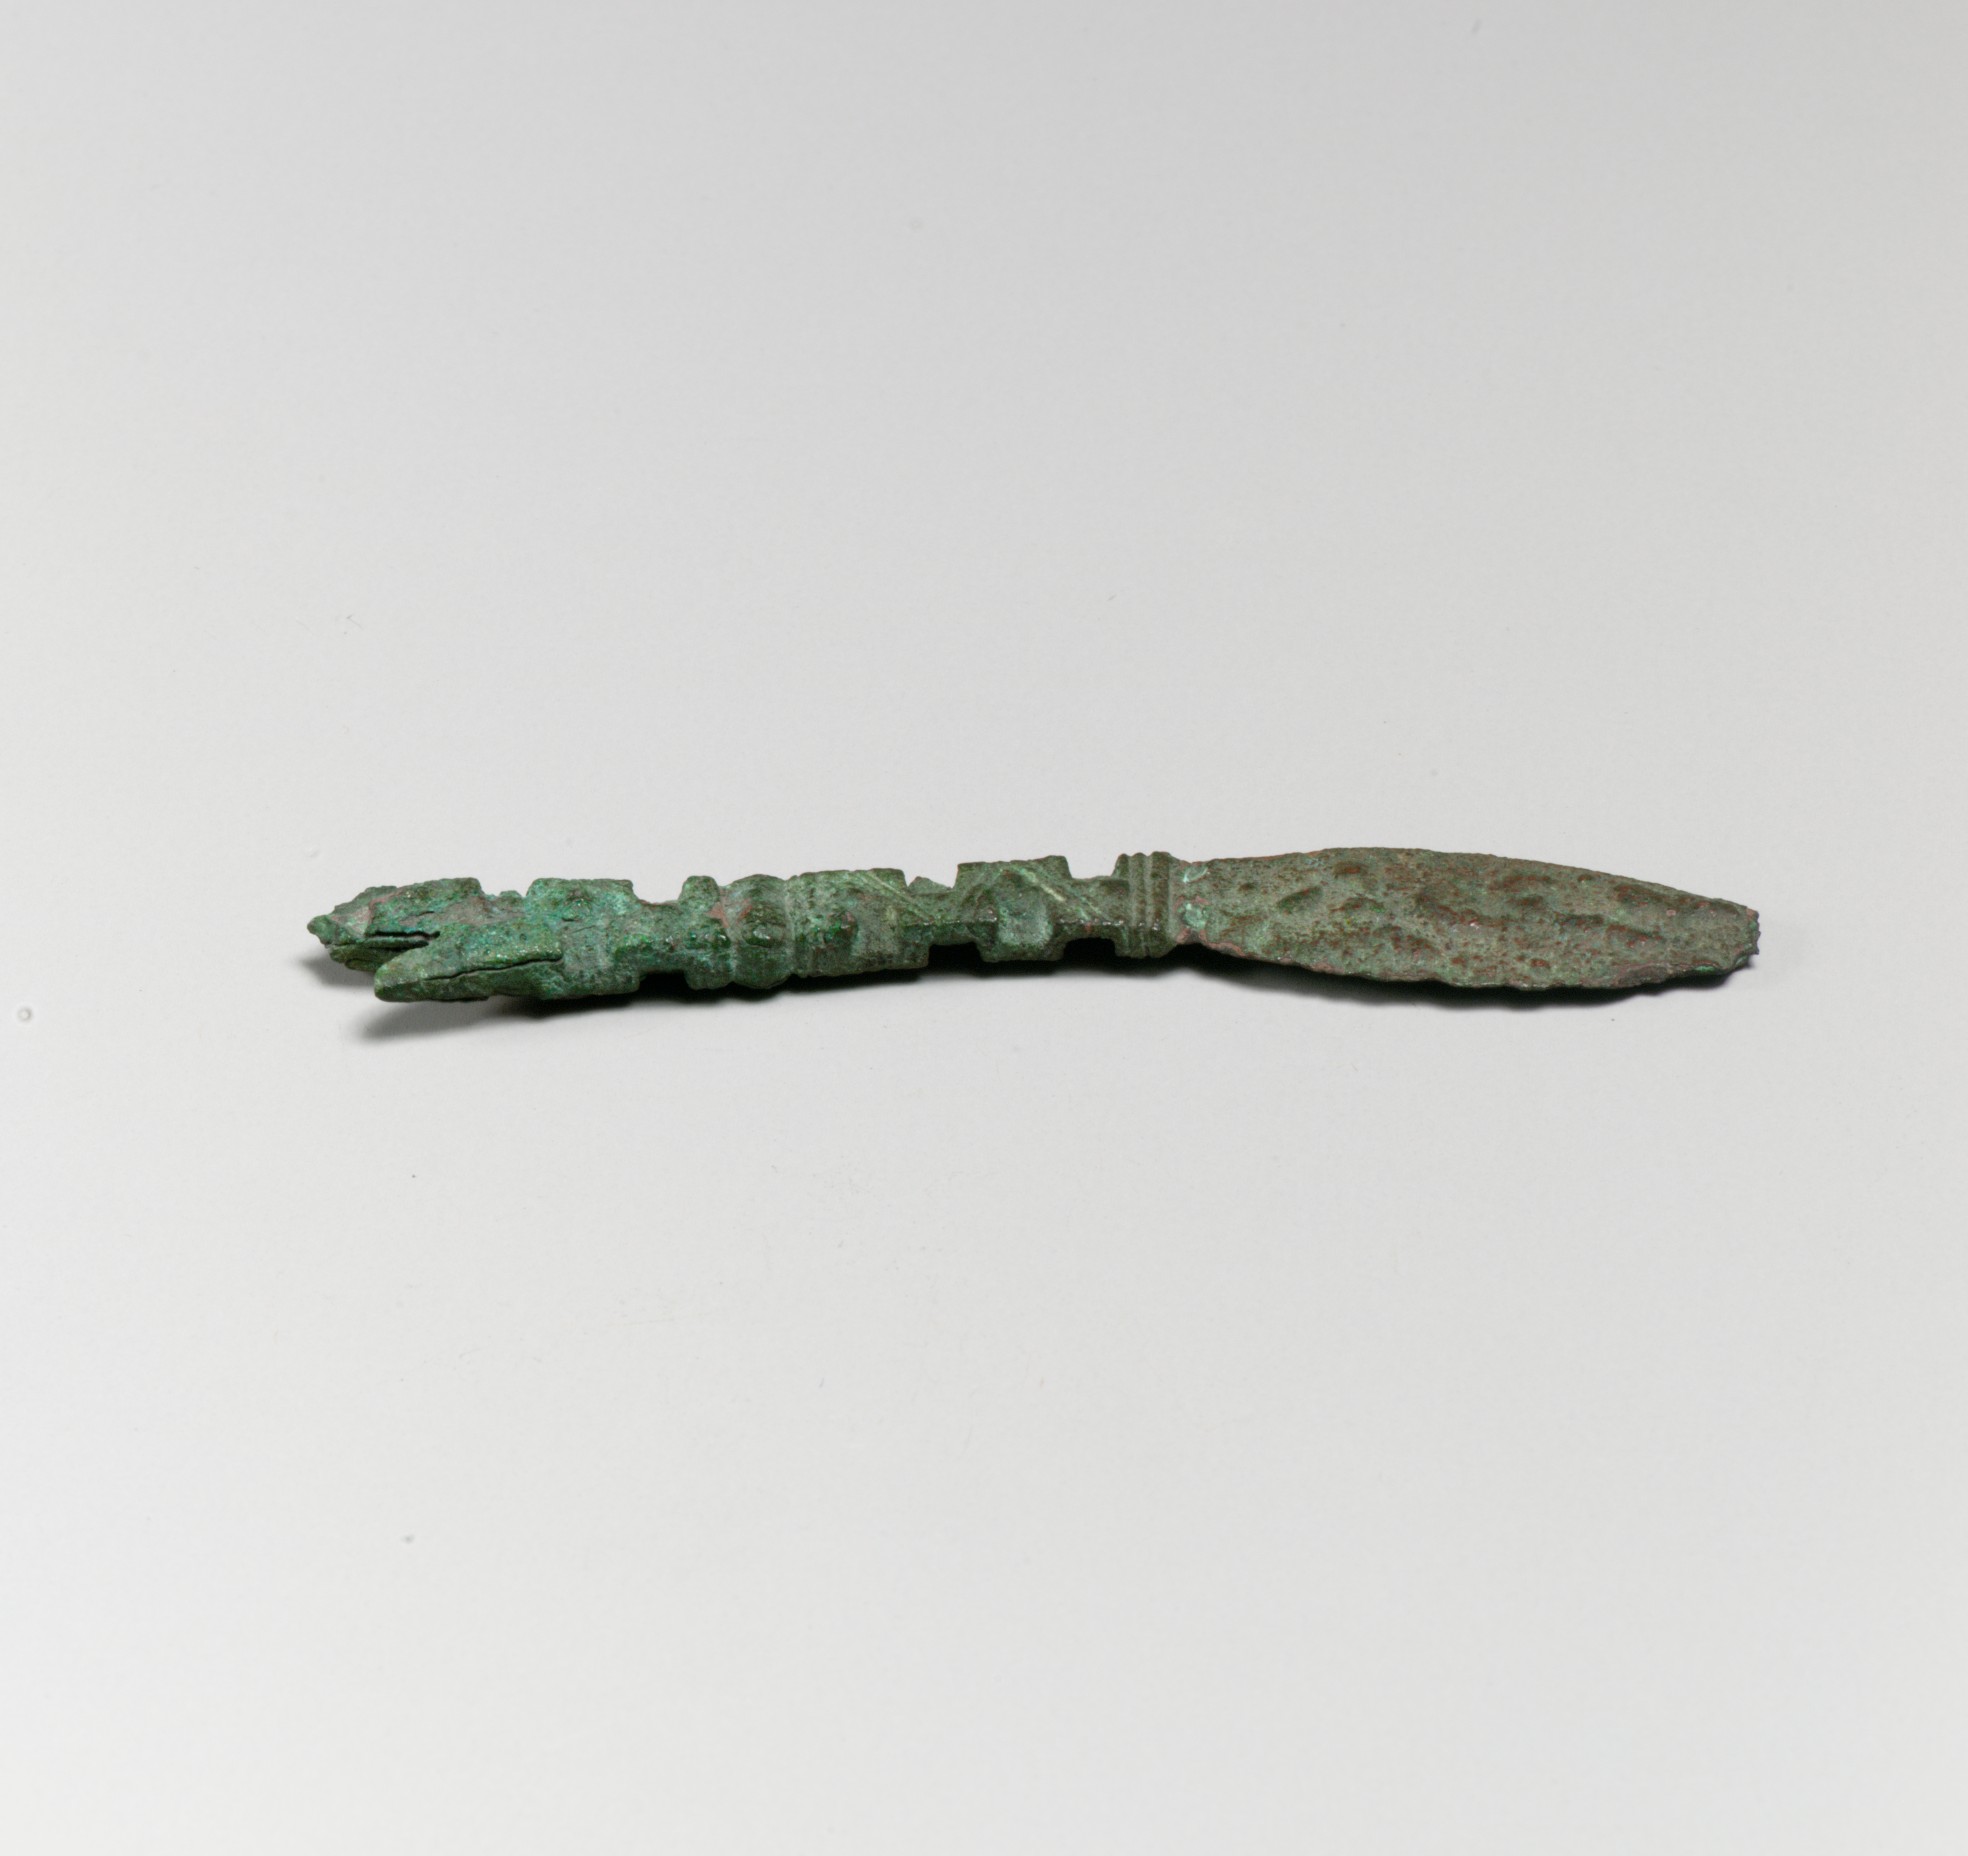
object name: knife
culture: roman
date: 1-300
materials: bronze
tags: knives